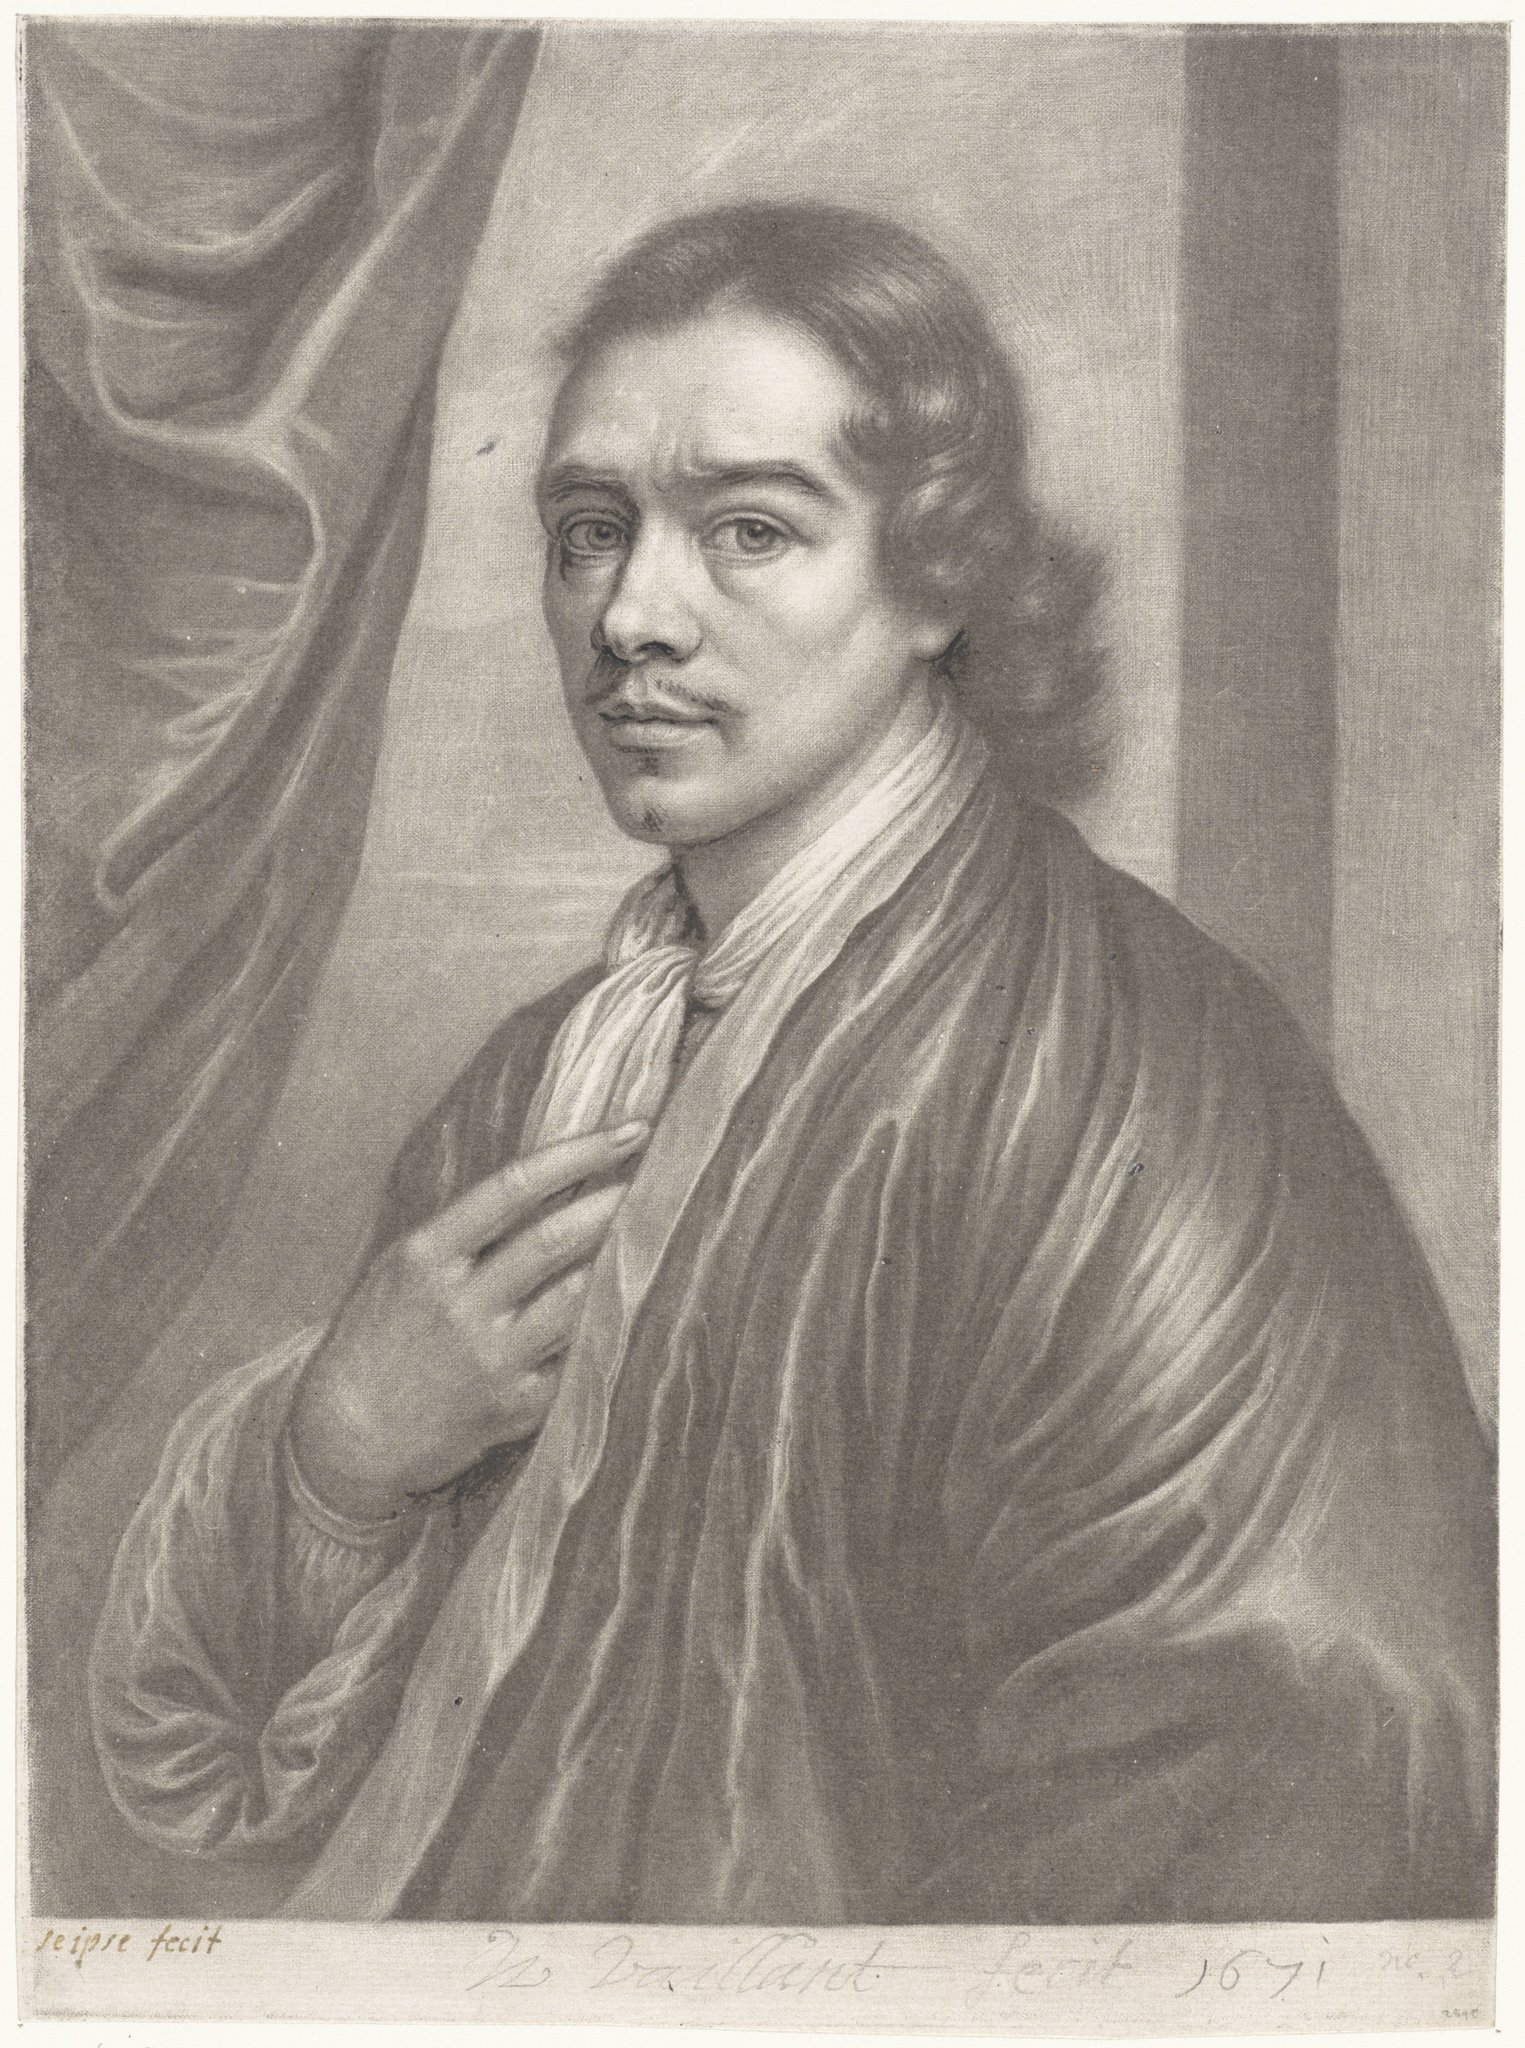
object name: print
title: Zelfportret van Wallerant Vaillant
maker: wallerant vaillant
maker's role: draughtsman, painter, print maker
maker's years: 1623-1677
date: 1671-1677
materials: ink, paper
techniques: brush, printmaking, pen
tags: lille, amsterdam, painter, print maker, draughtsman, wallerant vaillant, portrait, self-portrait of painter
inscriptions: collector's mark: Lugt 2228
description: De schilder, tekenaar en prentmaker Wallerant Vaillant staat voor een venster met een gordijn.